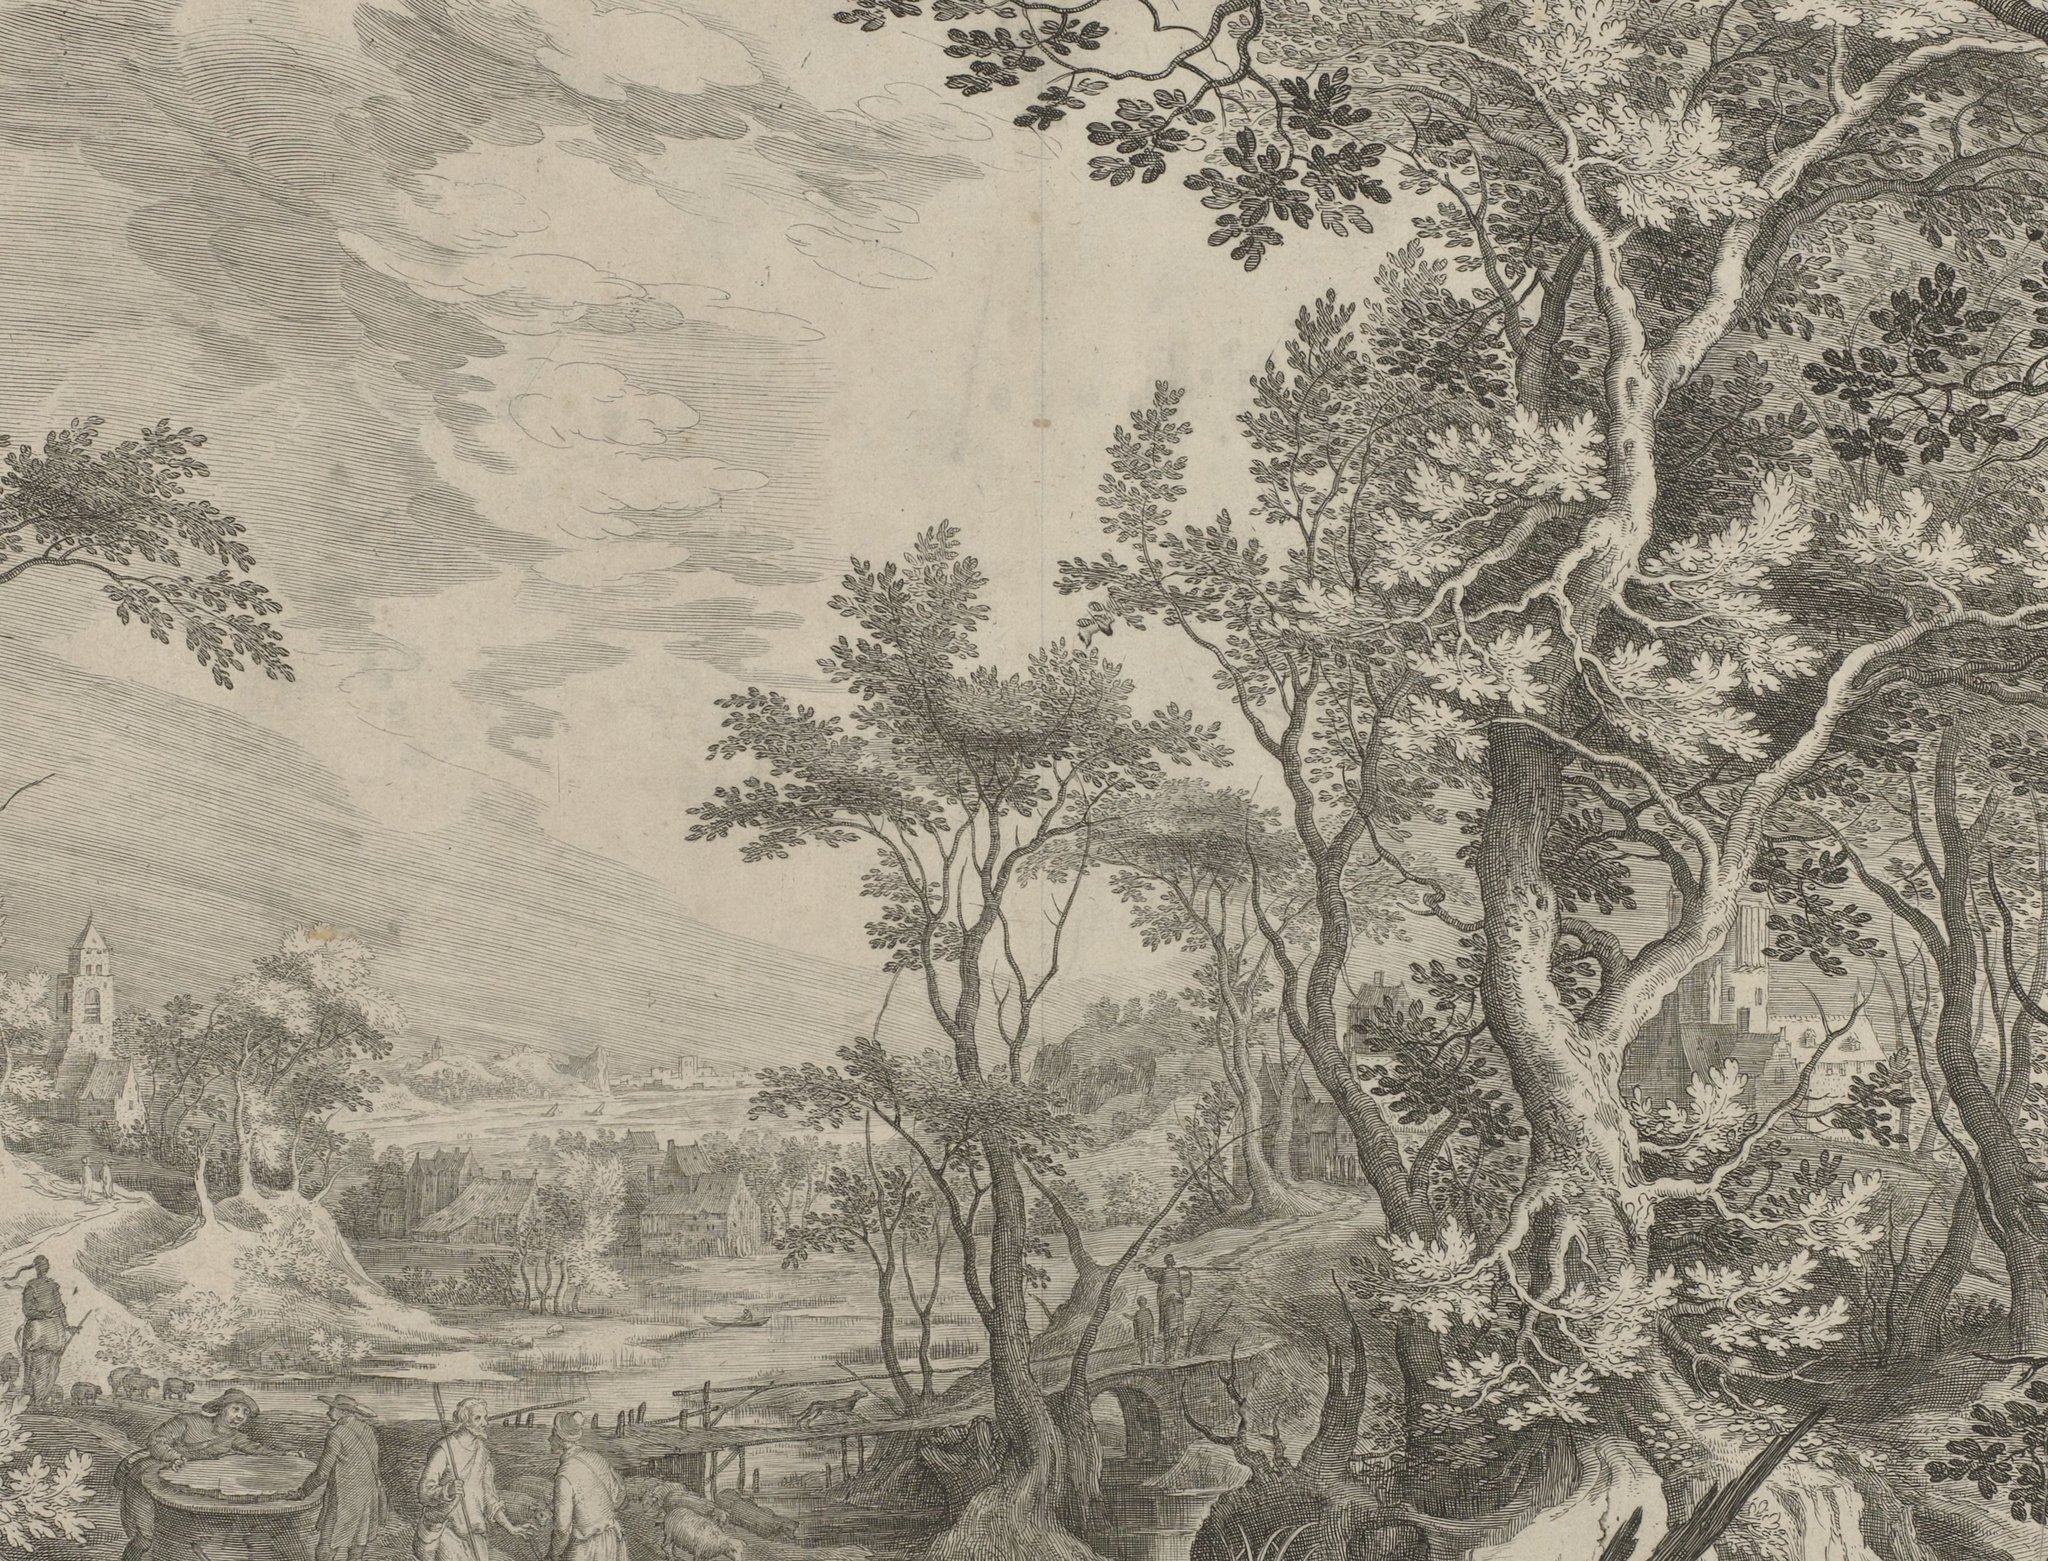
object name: print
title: Finibus ex patrijs profugo venit obuia Rachel Cognato figens (...)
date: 1585-1625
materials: paper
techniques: engraving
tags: landscapes with waters, waterscapes, seascapes (in the temperate zone), jacob at the well of haran (genesis 29:1-13)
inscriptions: collector's mark: Lugt 2228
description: De Amsterdamse uitgever Claes Jansz. Visscher (II) produceerde vanaf de jaren ’30 van de zeventiende eeuw grote Bijbelse prenten op zogenaamd royaal-formaat papier (ca. 480 x 580 mm). Na zijn dood in 1652 zette zijn zoon Nicolaes Visscher (I) het bedrijf voort en zo ook de uitgave van Royaalbijbelprenten. Toen Nicolaes in 1679 overleed nam zijn zoon Nicolaes Visscher (II) het bedrijf over en gaf kort hierna, omstreeks 1680, een fondslijst uit. Hierin worden 130 prenten met Bijbelse voorstellingen op royaalpapier beschreven (zie documentatie J. van der Waals). Complete prentbijbels op royaal-formaat werden door vader en zoon Nicolaes Visscher uitgegeven onder de titel Historiae Sacrae Veteris et Novi Testamenti. De bladen werden echter ook los verkocht en konden worden gecombineerd met Royaalbijbel-prenten van andere uitgevers. Verschillende Amsterdamse uitgevers brachten namelijk ook bijbelprenten op royaal-formaat uit, onder wie Clement de Jonghe en Cornelis Danckerts. De door de firma Visscher uitgegeven prenten zijn veelal vervaardigd door anonieme prentmakers naar voorbeeld van verschillende zestiende- en zeventiende-eeuwse Bijbelse prenten en prentreeksen. Veelal moesten de composities worden aangepast aan het grotere en langgerekte royaal-formaat. Daarnaast zijn er ook grote bladen van bekende prentmakers zoals Jan van Londerseel, Pieter Nolpe, Jacques de Gheyn (II) en Jan Harmensz. Muller opgenomen in de categorie ‘Bybelsche Figuren, op Royaal-bladen’ in de fondslijst van Visscher. Prent mogelijk gebruikt in: Historiae Sacrae Veteris et Novi Testamenti (Royaalbijbel). Amsterdam: Nicolaes Visscher (I) en (II), [1652-1702]. In de fondslijst van Nicolaes Visscher II (ca. 1680) is het onderwerp van deze prent onder de titel 'Bybelsche Figuren, op Royaal-bladen. bestaande uyt de volgende historien.' als volgt genummerd: 16.